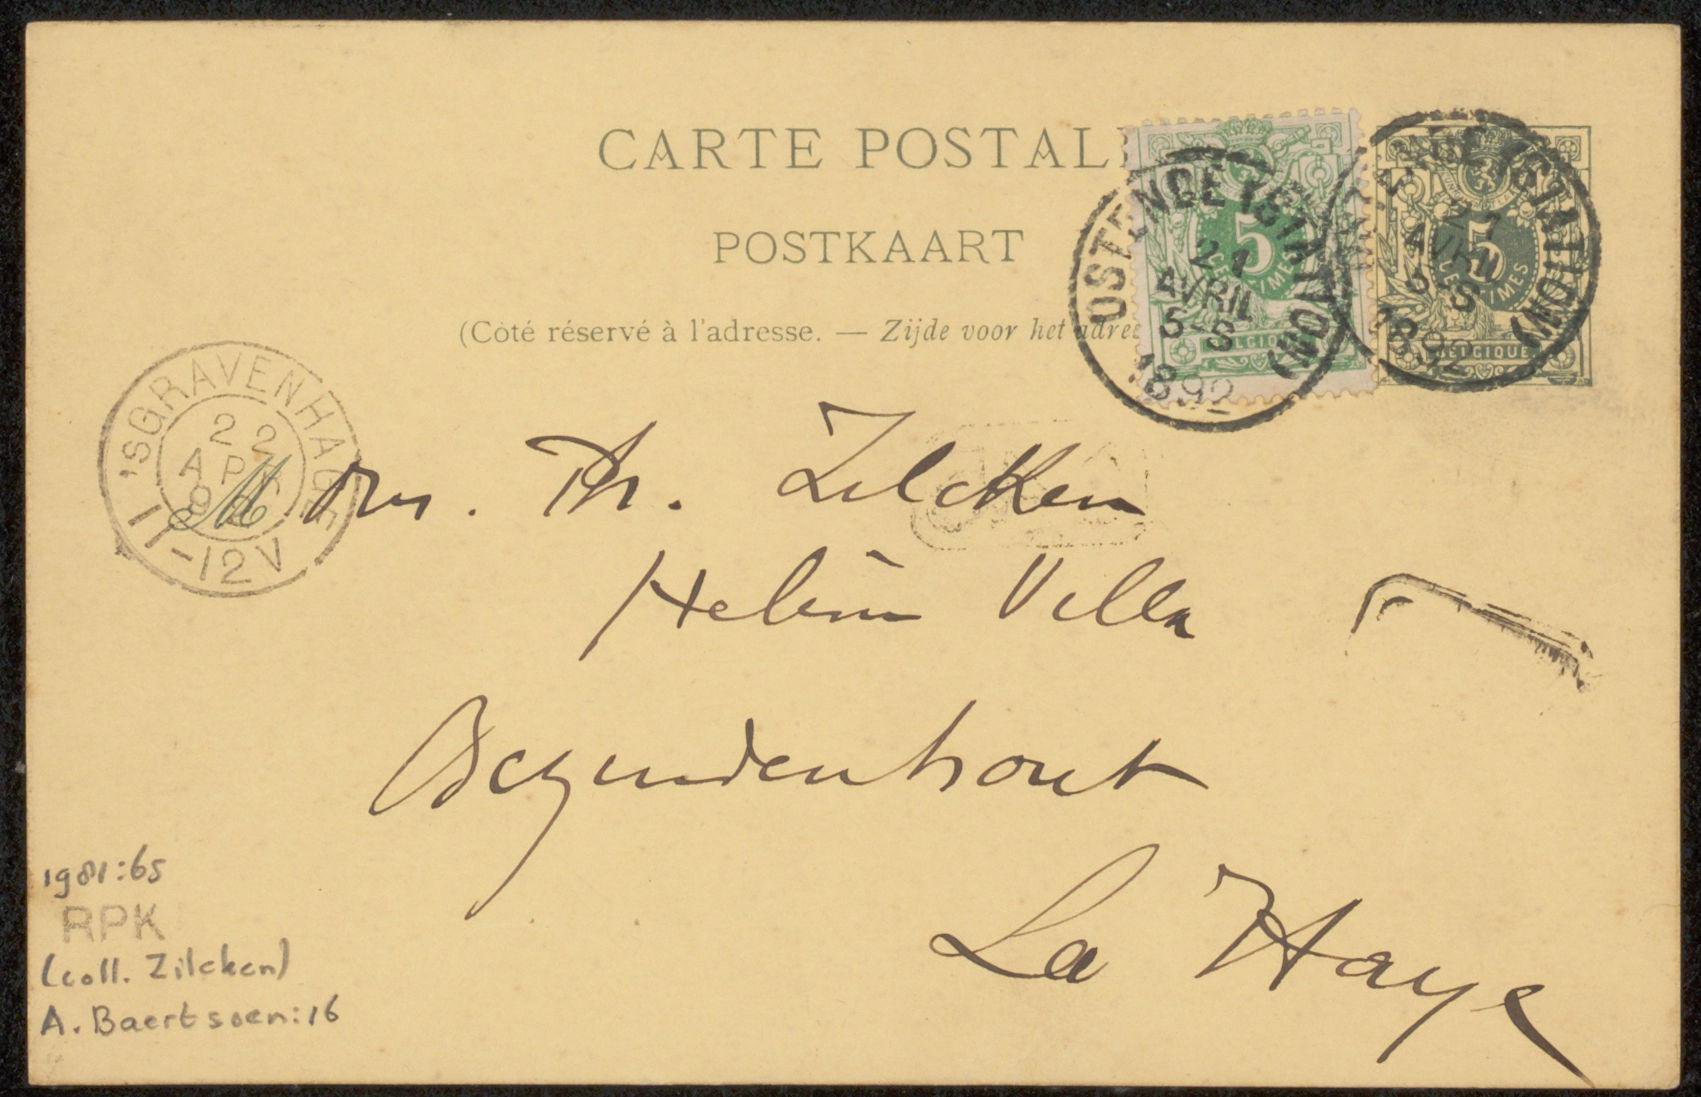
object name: postcard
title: Briefkaart aan Philip Zilcken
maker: albert baertsoen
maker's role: draughtsman, print maker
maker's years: 1866-1922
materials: cardboard, ink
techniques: pen, writing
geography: oostende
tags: the hague, painter, draughtsman, philip zilcken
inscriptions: collector's mark: ‘RPK’